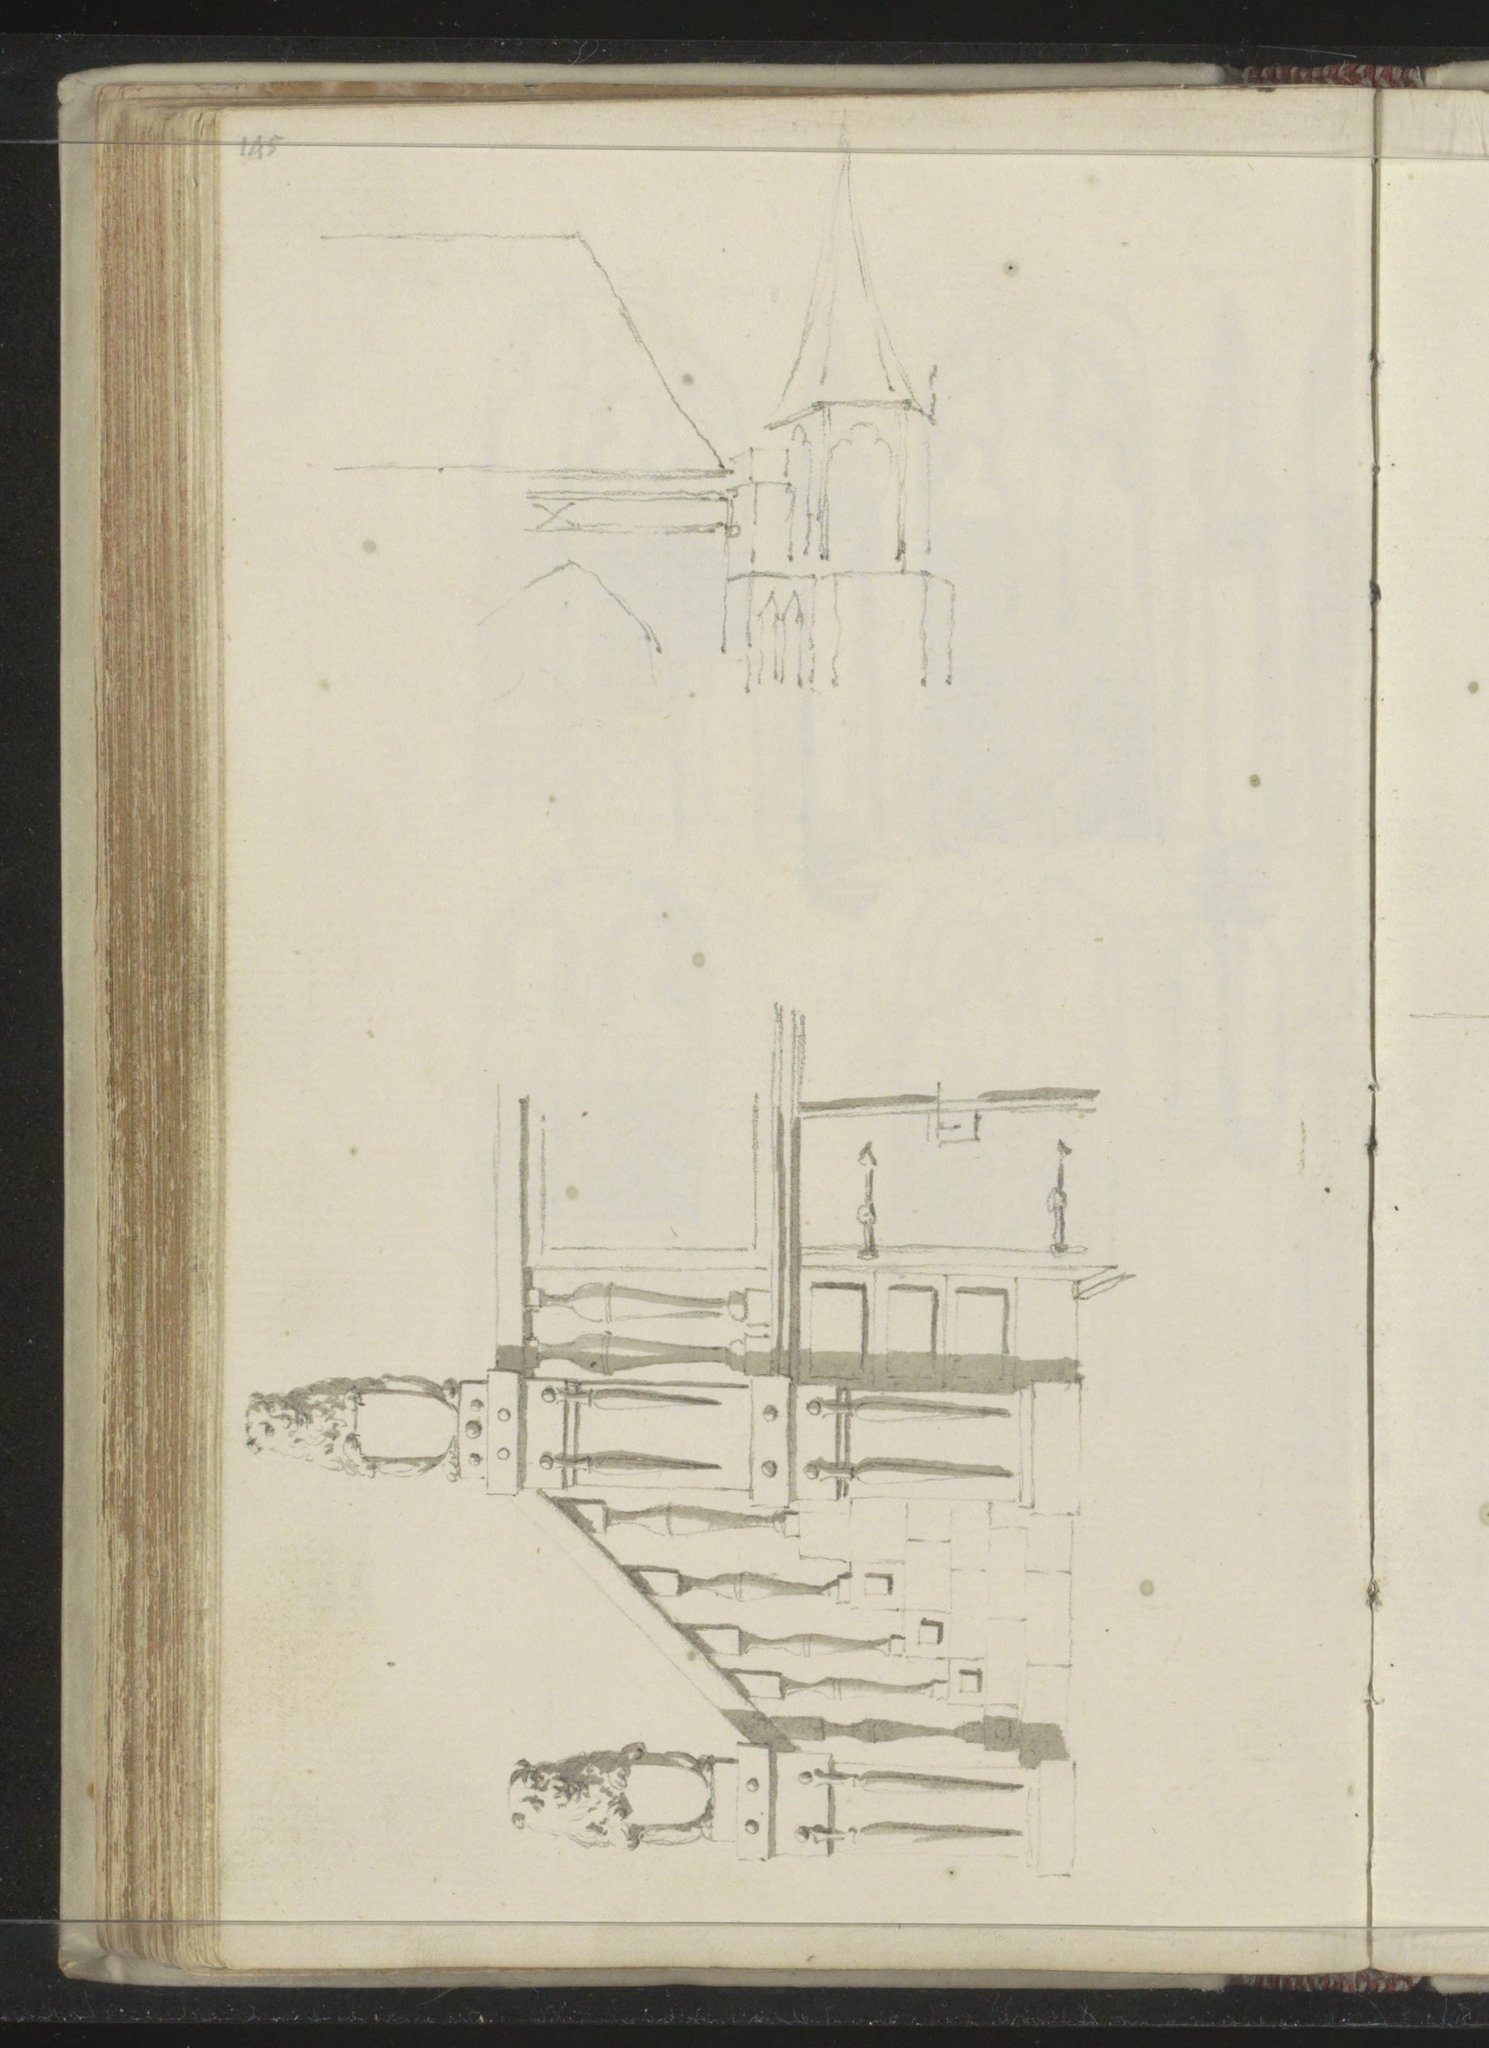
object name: sketchbook leaf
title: Bordestrap en een torenspits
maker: johannes huibert prins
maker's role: draughtsman, painter, print maker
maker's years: 1757-1806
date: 1783-1797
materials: paper, pencil, watercolor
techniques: brush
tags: spire (of tower on house or building), front steps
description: Pagina 145 uit een schetsboek met 175 pagina's.